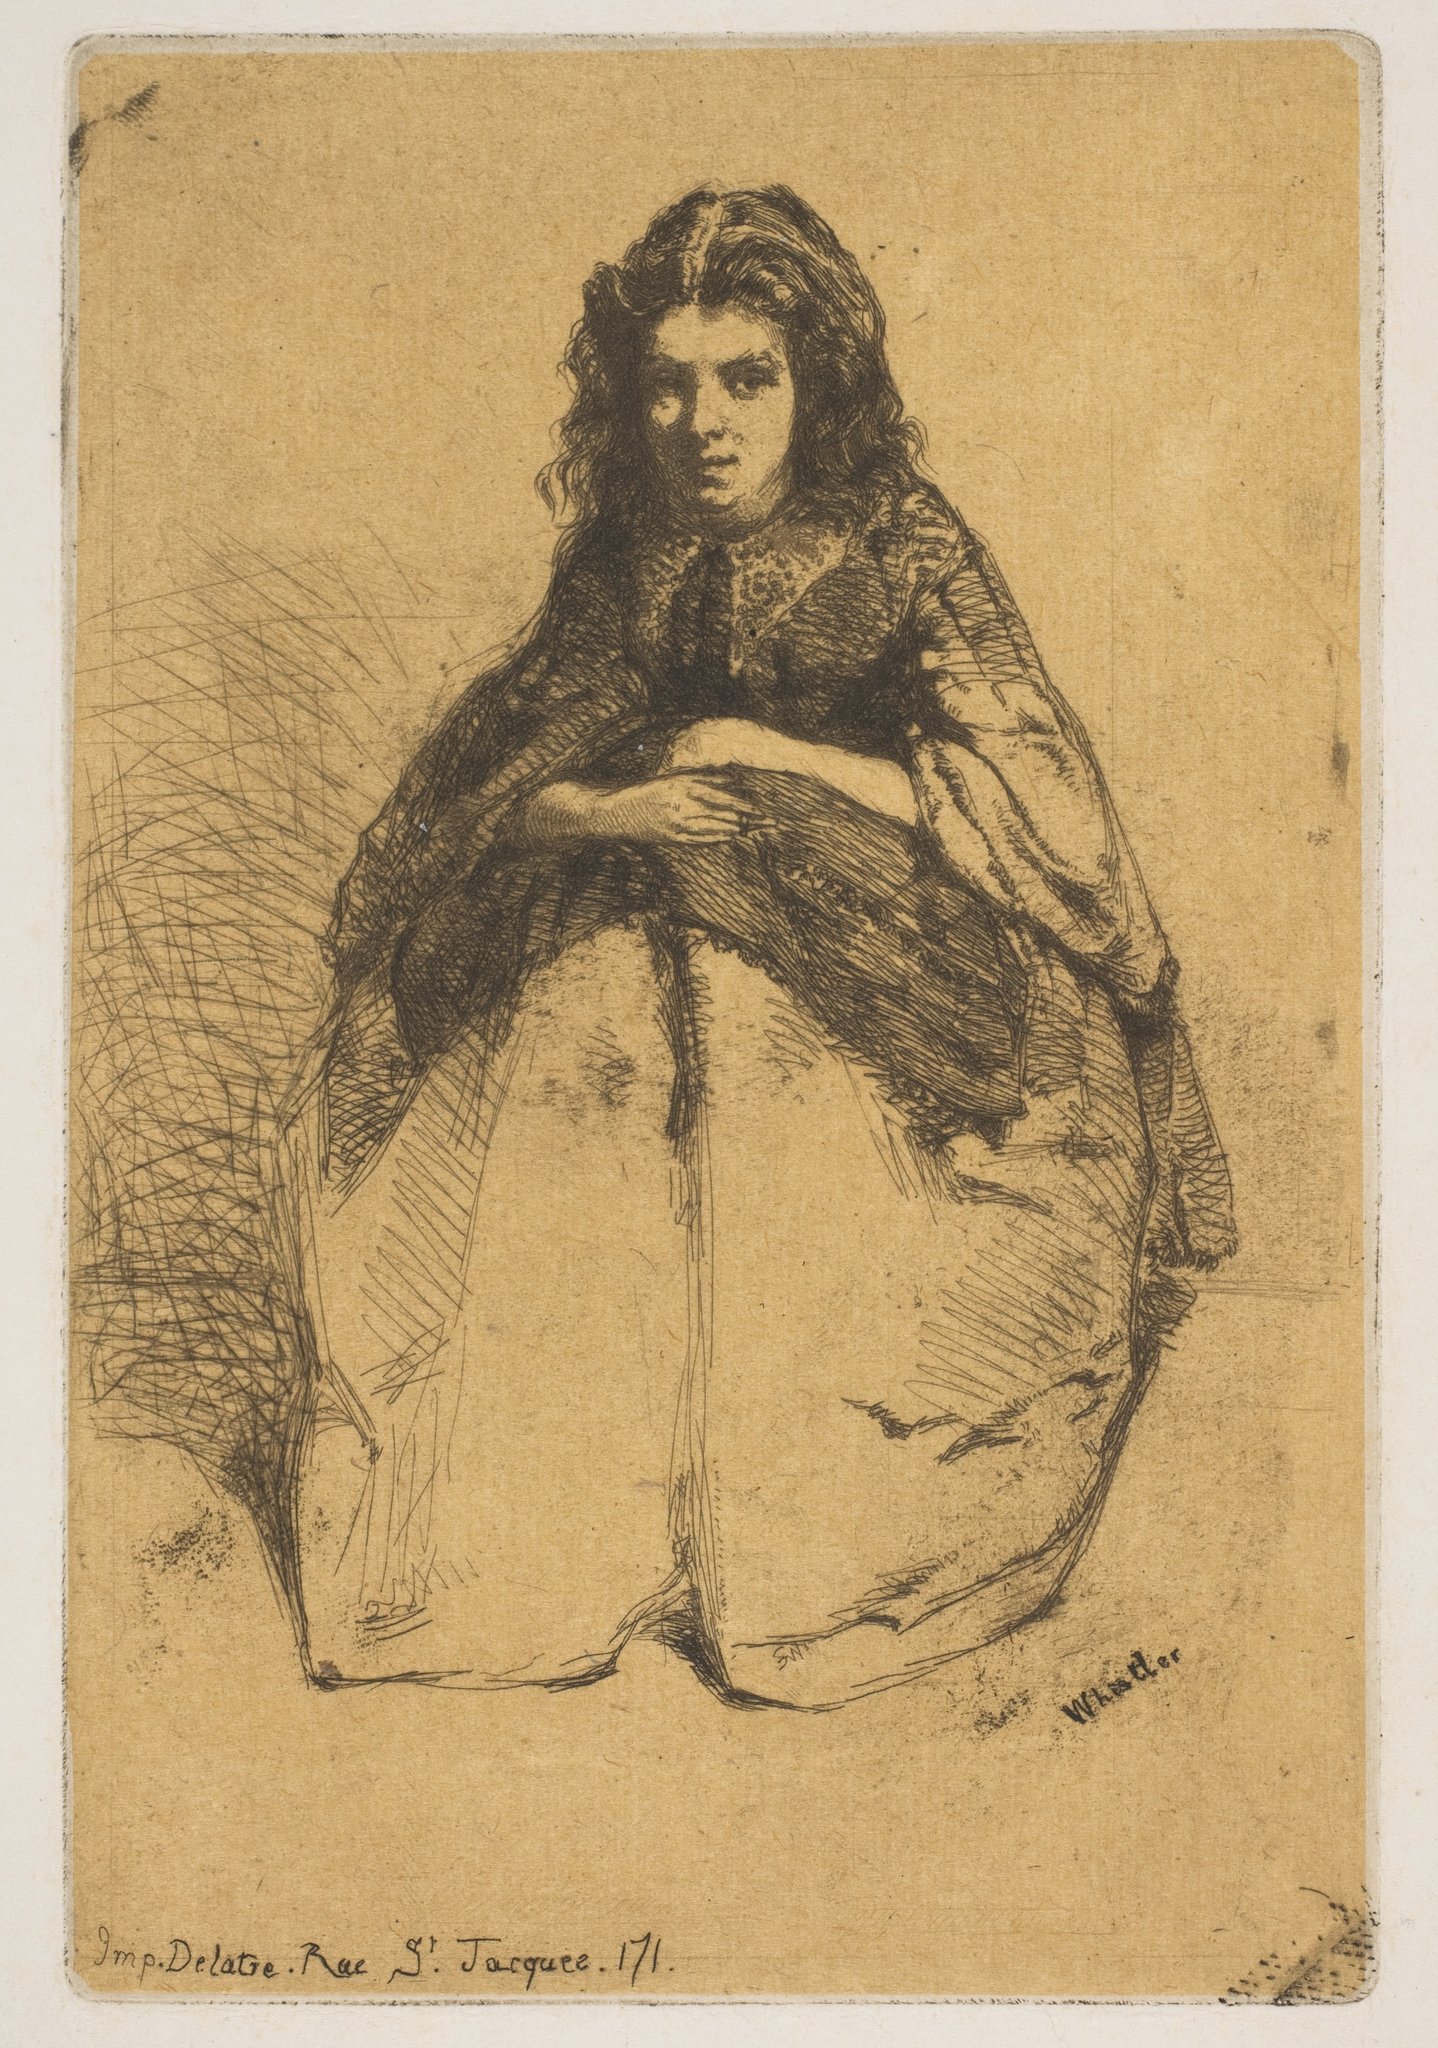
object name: print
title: Fumette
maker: james mcneill whistler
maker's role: artist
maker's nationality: american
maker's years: 1834-1903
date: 1858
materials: chine, paper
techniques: printmaking, etching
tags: women